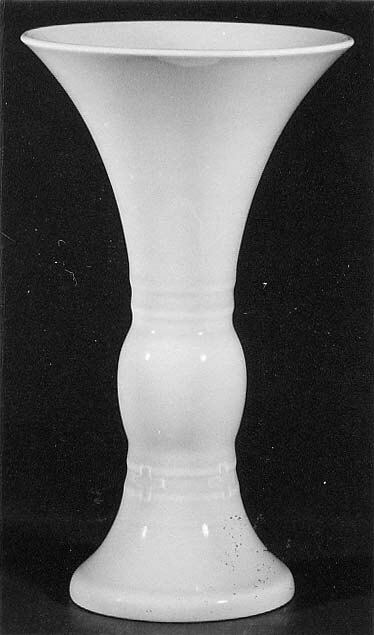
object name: vase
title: Vase in the shape of an ancient ritual beaker (gu)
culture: chinese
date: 1901-1933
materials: glaze, porcelain